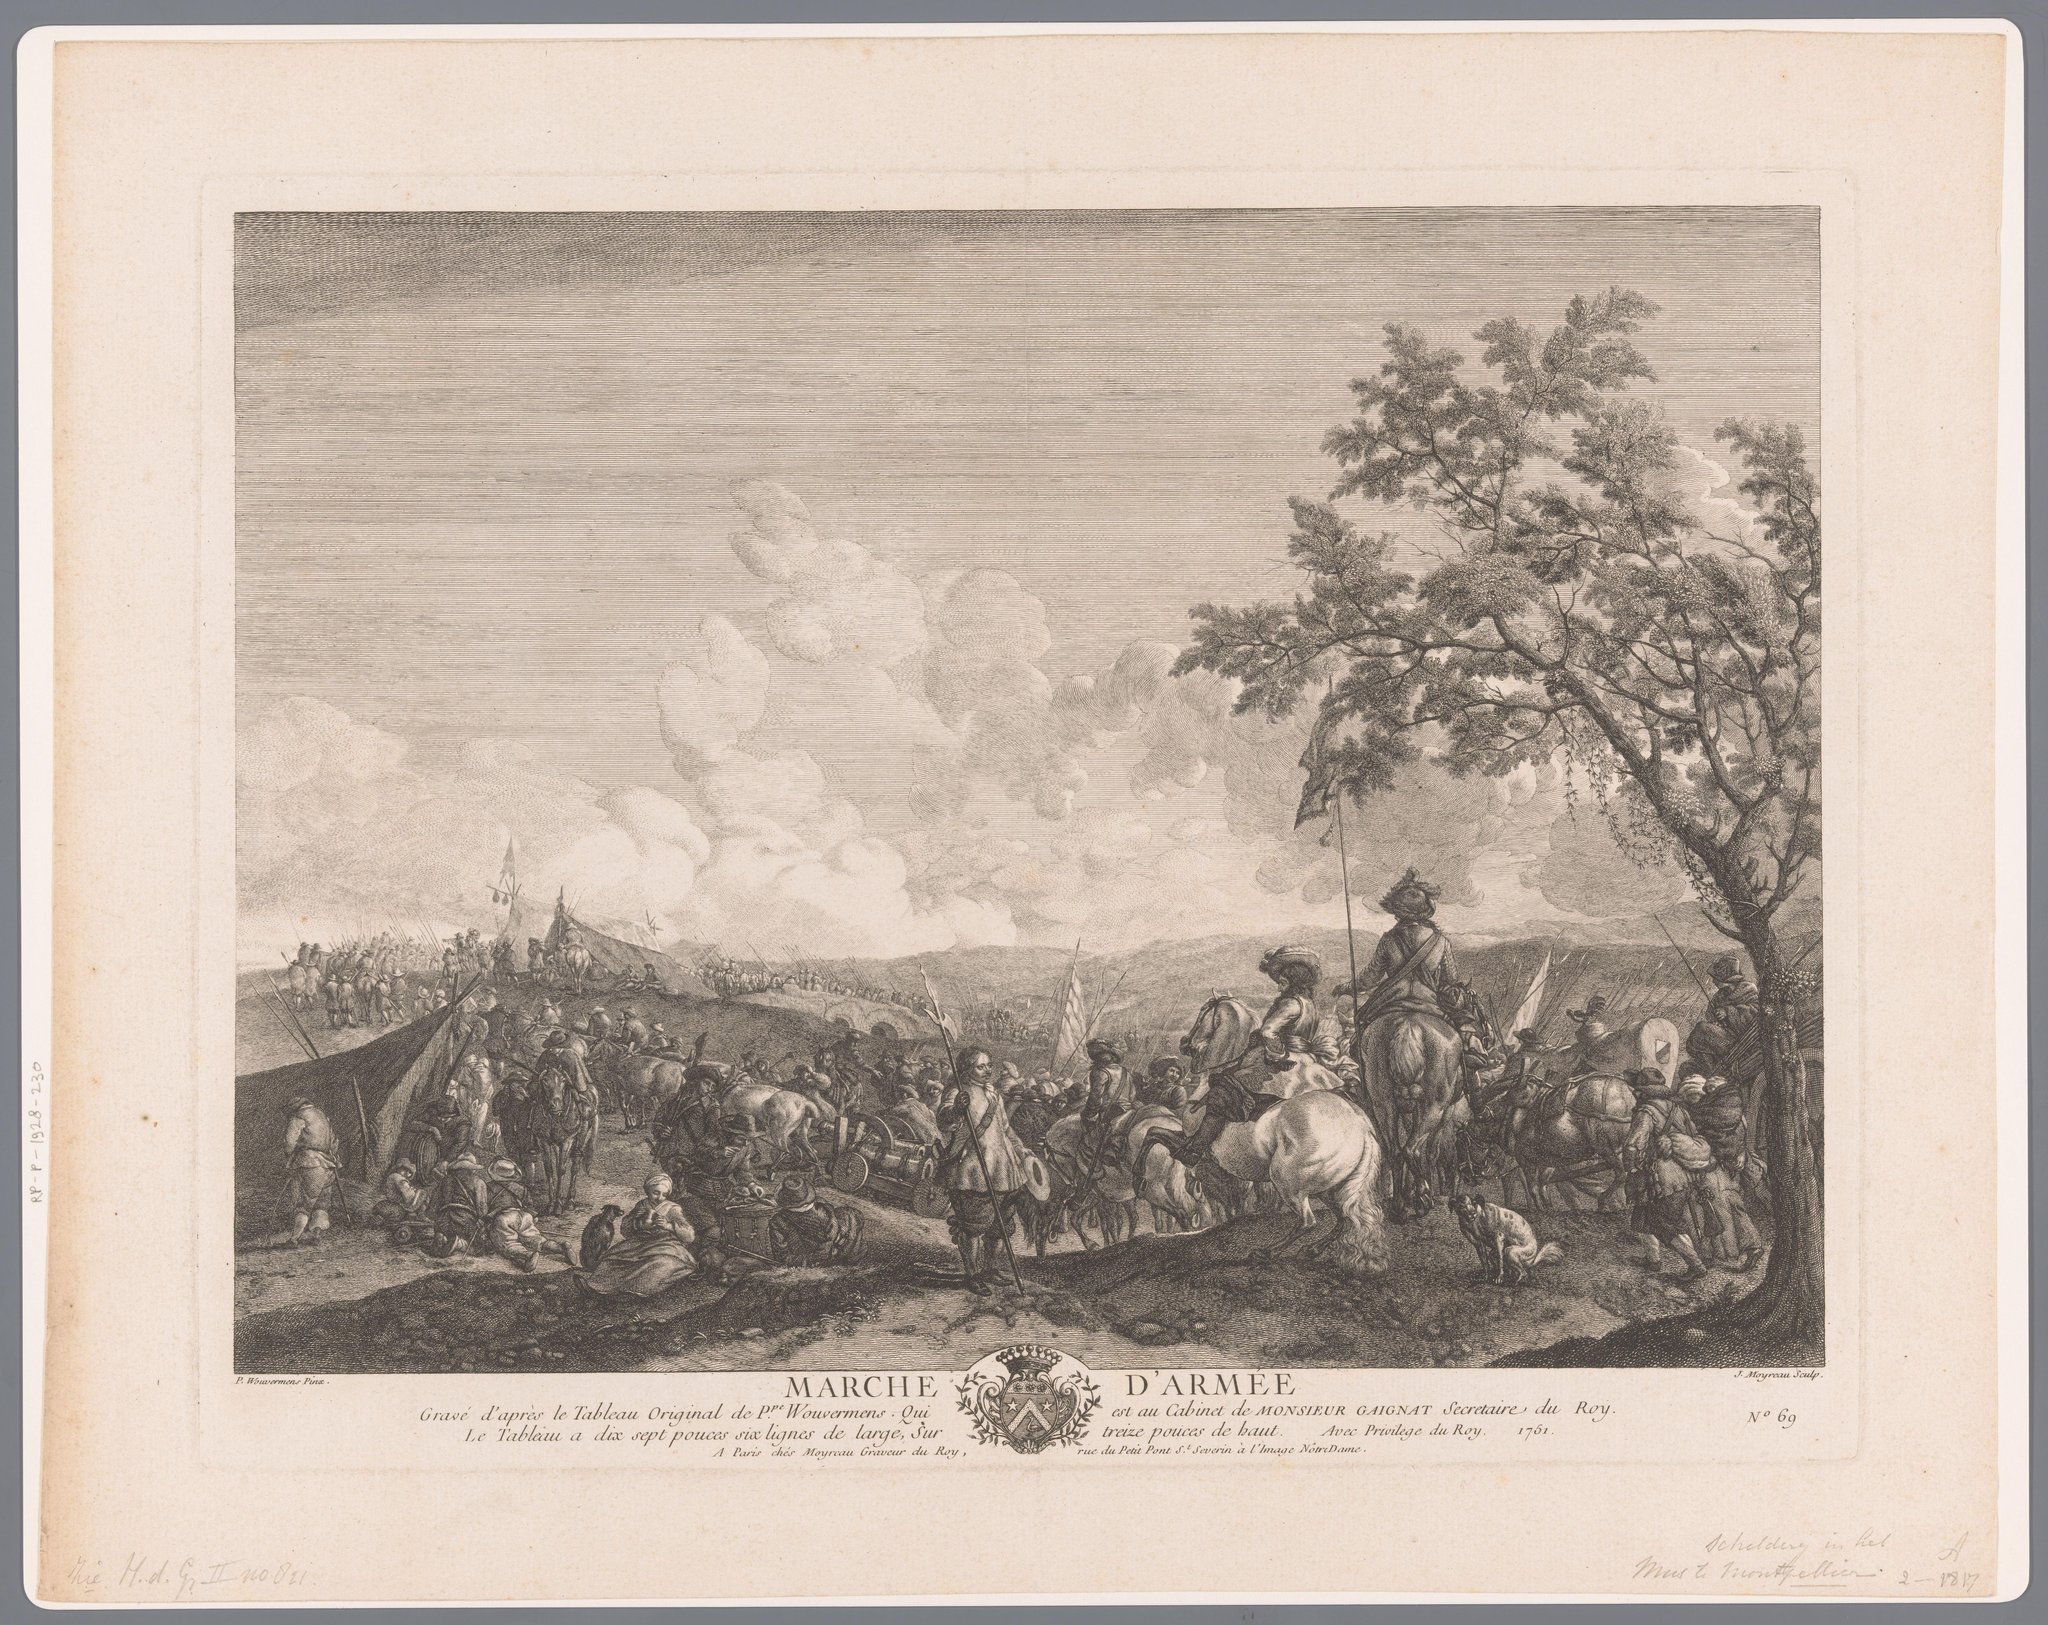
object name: print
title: Soldaten en aanvoerders in een legerkamp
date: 1751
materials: paper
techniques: engraving, etching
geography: paris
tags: (military) camp with tents, land forces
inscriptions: collector's mark: Lugt 2228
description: Maakt deel uit van een serie van 89 prenten te dateren tussen ca. 1733-1762, naar het geschilderde oeuvre van Philips Wouwerman.